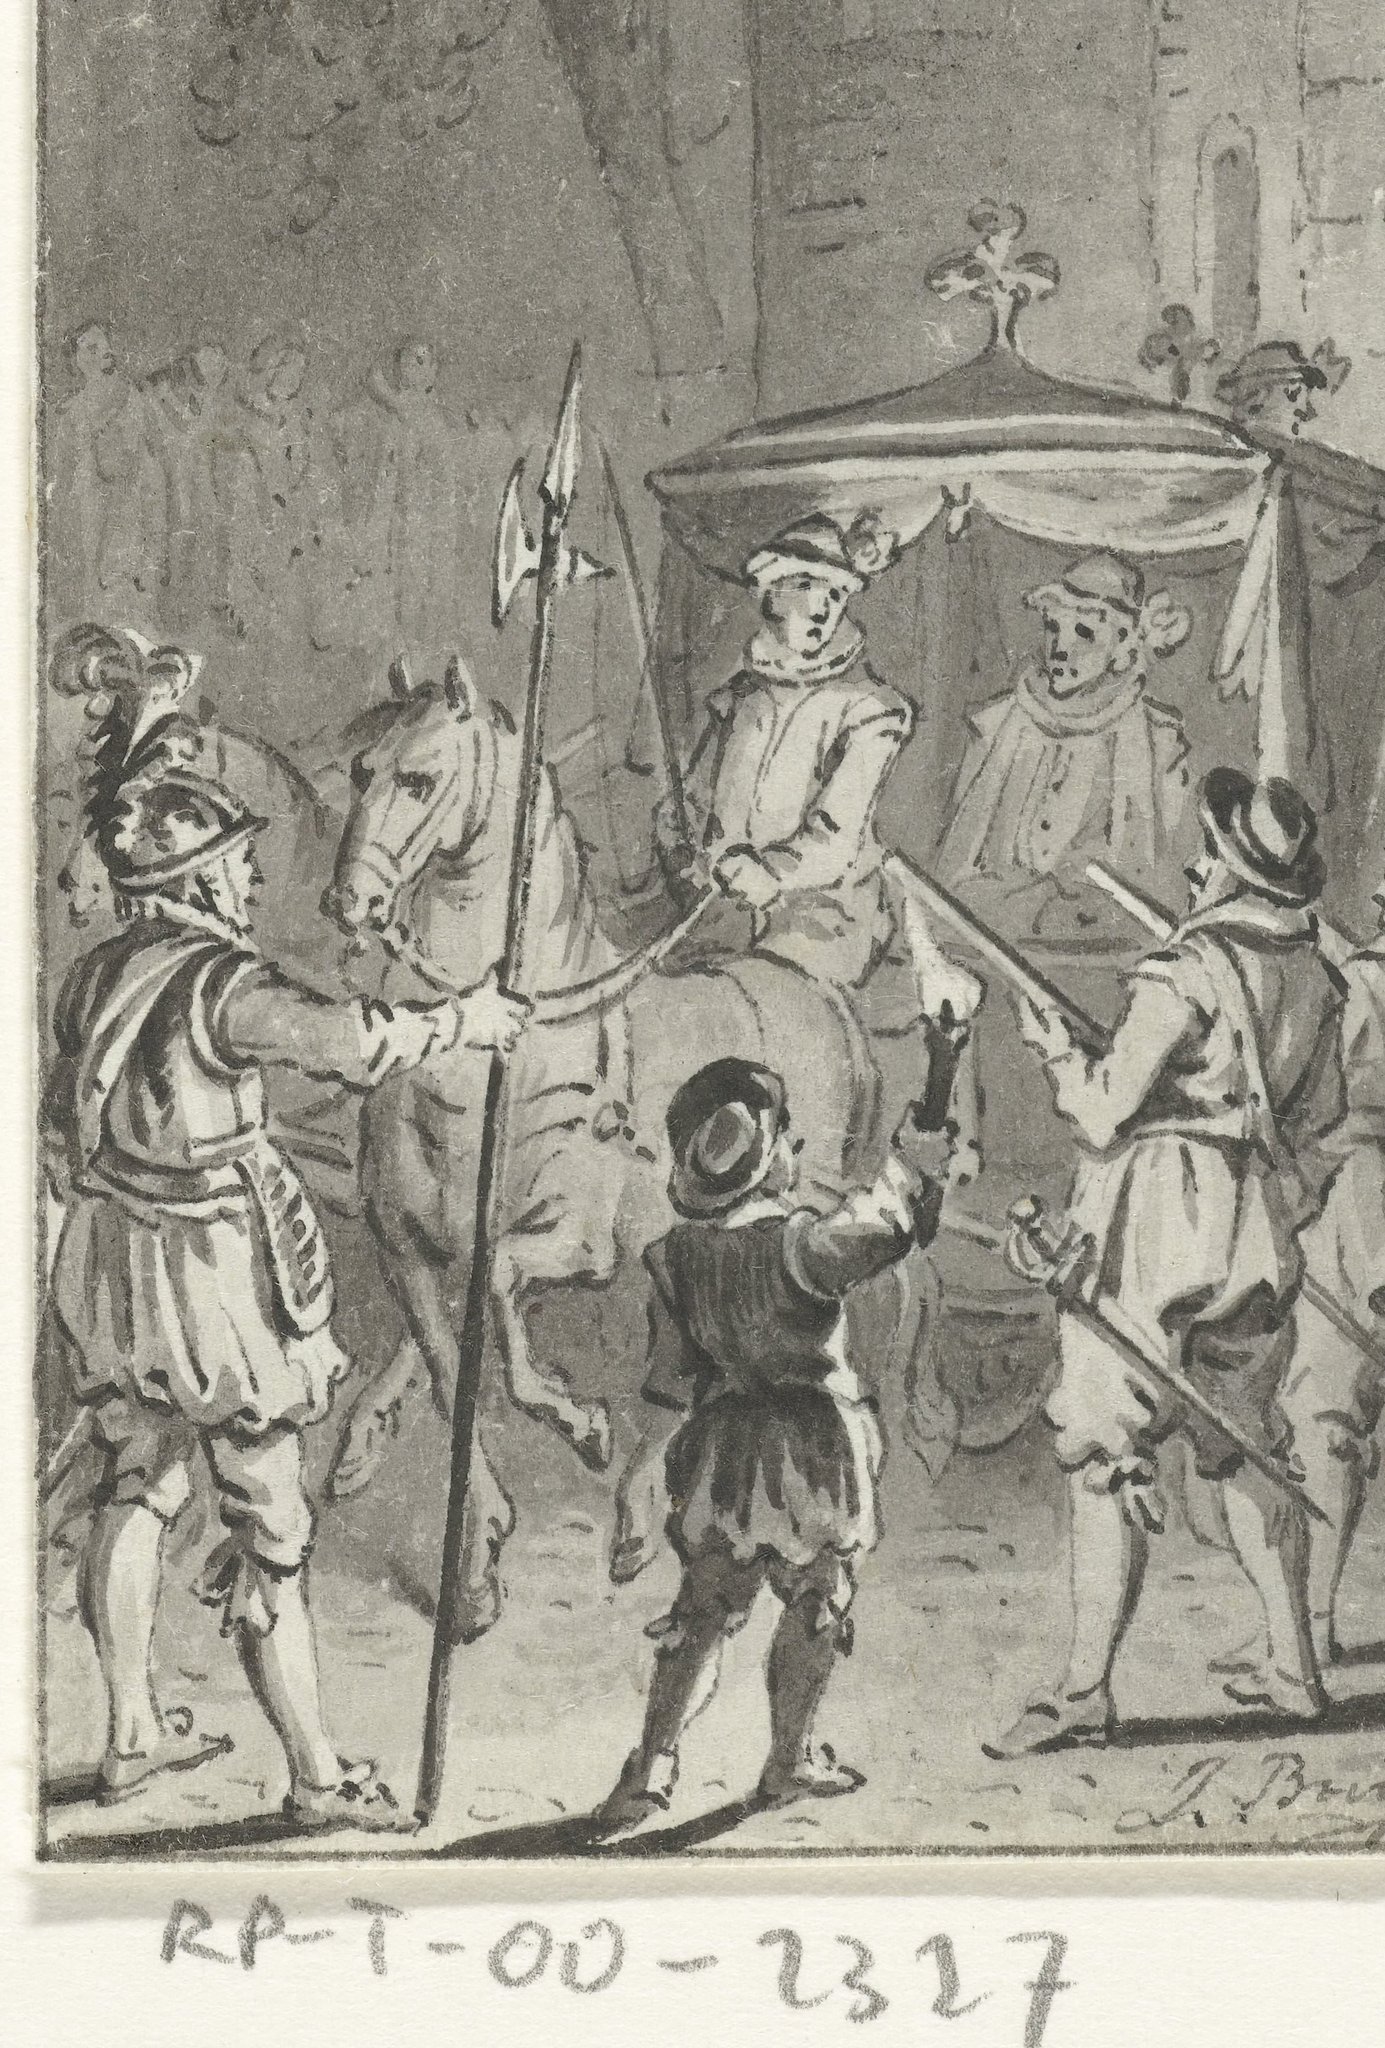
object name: drawing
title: De aankomst van de graaf van Leicester te Amsterdam, 1585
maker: jacobus buys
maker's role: draughtsman, print maker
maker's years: 1724-1801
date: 1780-1795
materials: ink, paper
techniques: brush, pen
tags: robert dudley (1st earl of leicester), historical persons, historical events and situations, amsterdam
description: Ontwerptekening voor illustratie in: J. Fokke, Geschiedenissen der Vereenigde Nederlanden voor de vaderlandsche jeugd, Johannes Allart, Amsterdam 1783-1795, 25 delen, dl. VI, pl. II.